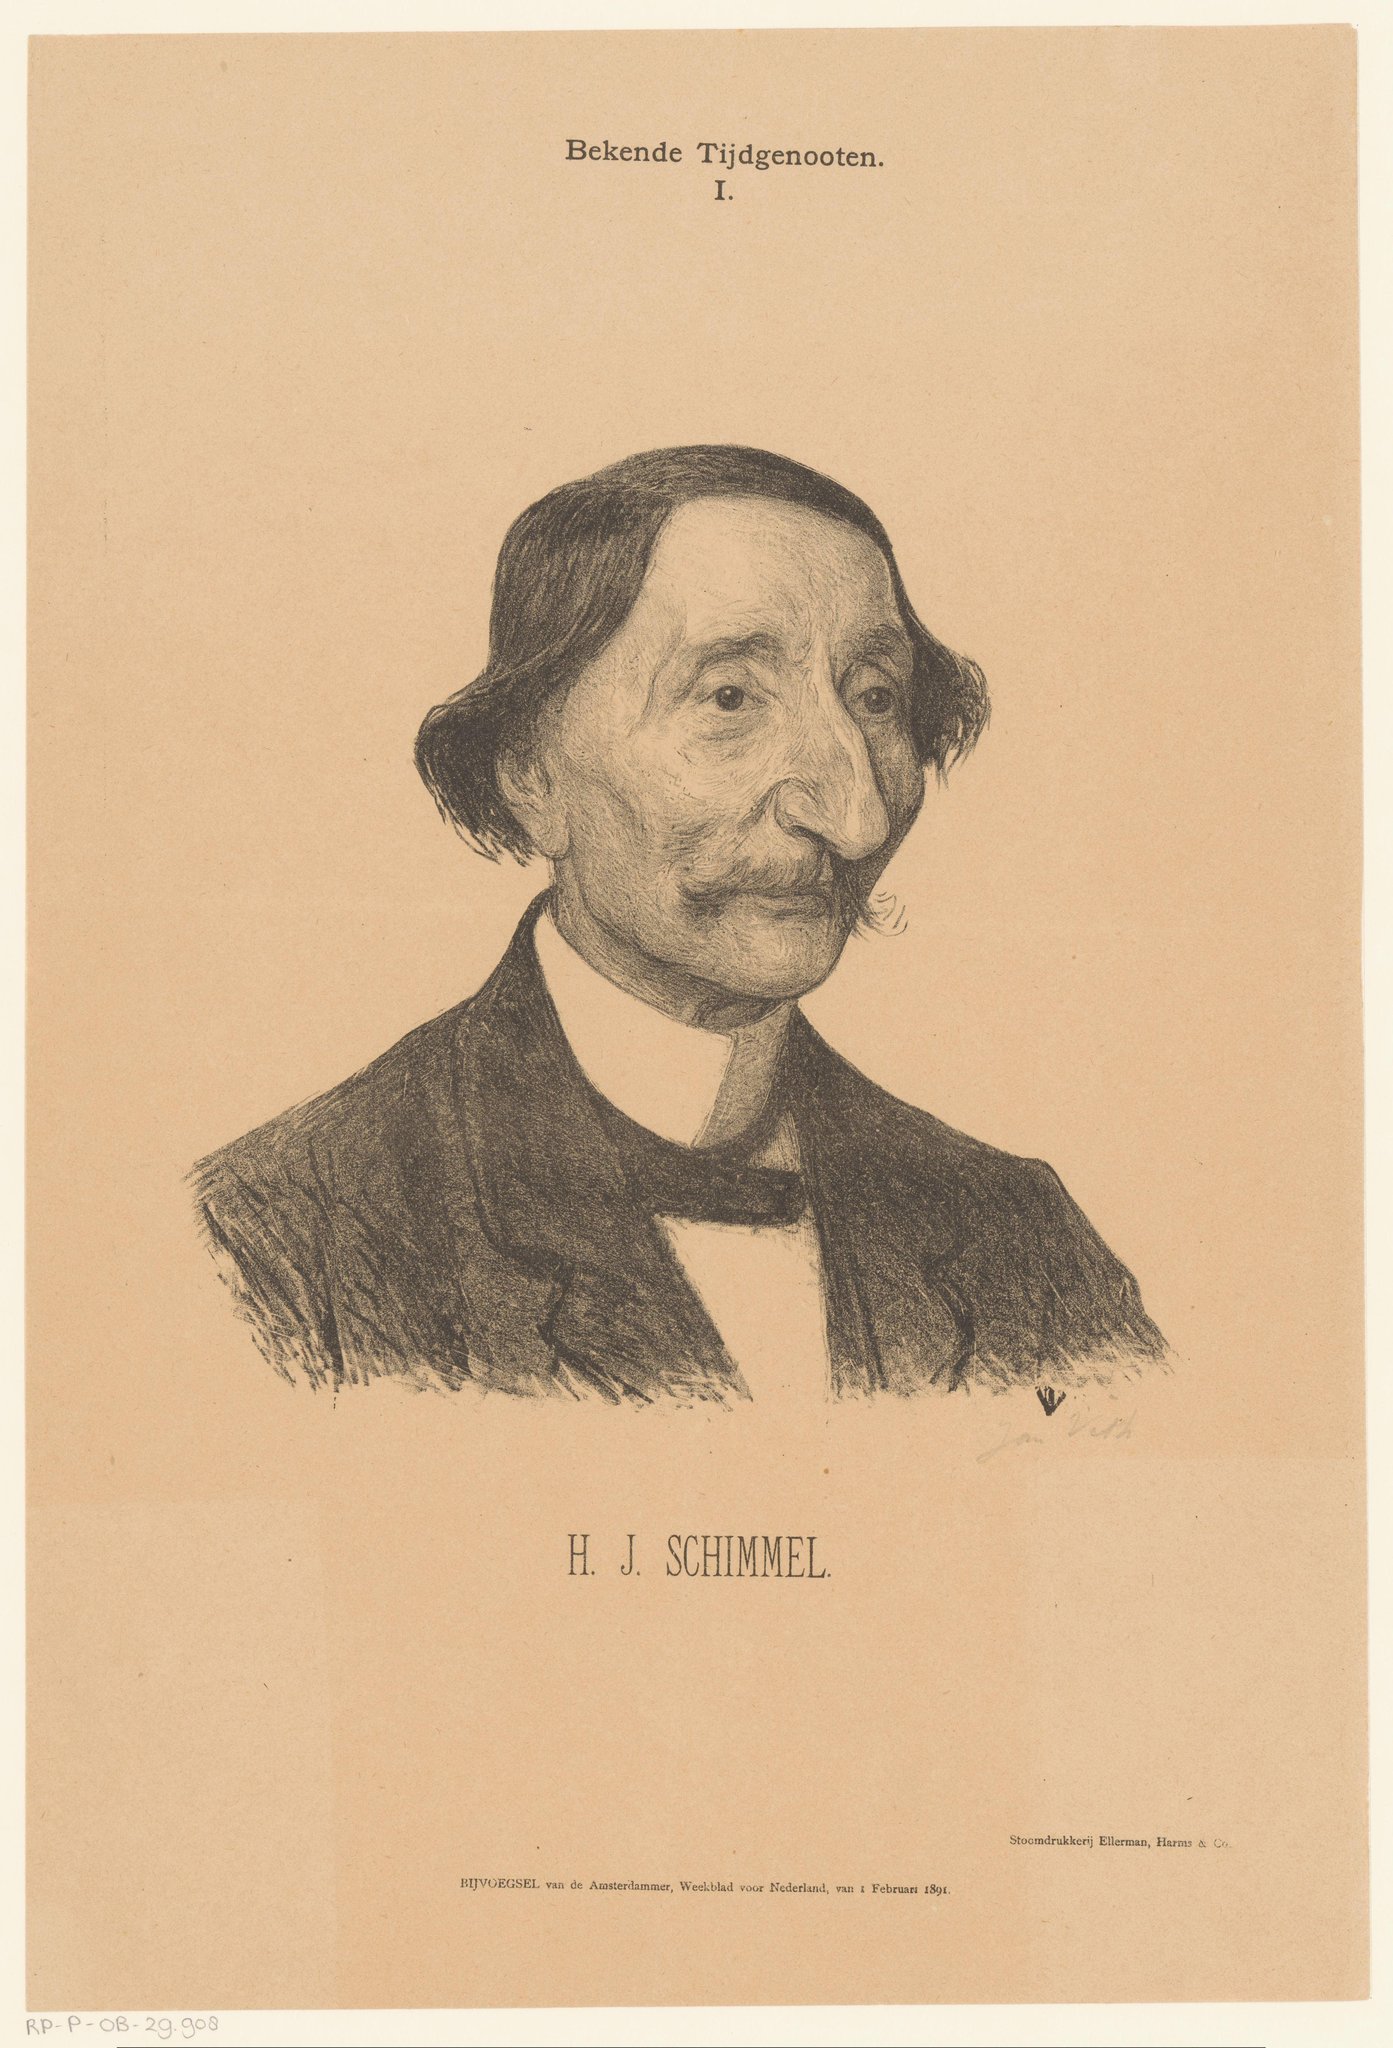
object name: print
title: Bekende tijdgenooten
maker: jan veth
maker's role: designer, draughtsman, painter, print maker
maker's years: 1864-1925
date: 1891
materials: paper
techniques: lithograph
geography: amsterdam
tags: hendrik jan schimmel, historical persons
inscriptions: collector's mark: Lugt 2228, inscription: ‘Jan Veth’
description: Deze prent werd uitgegeven als bijvoegsel van De Amsterdammer op 1 februari 1891.